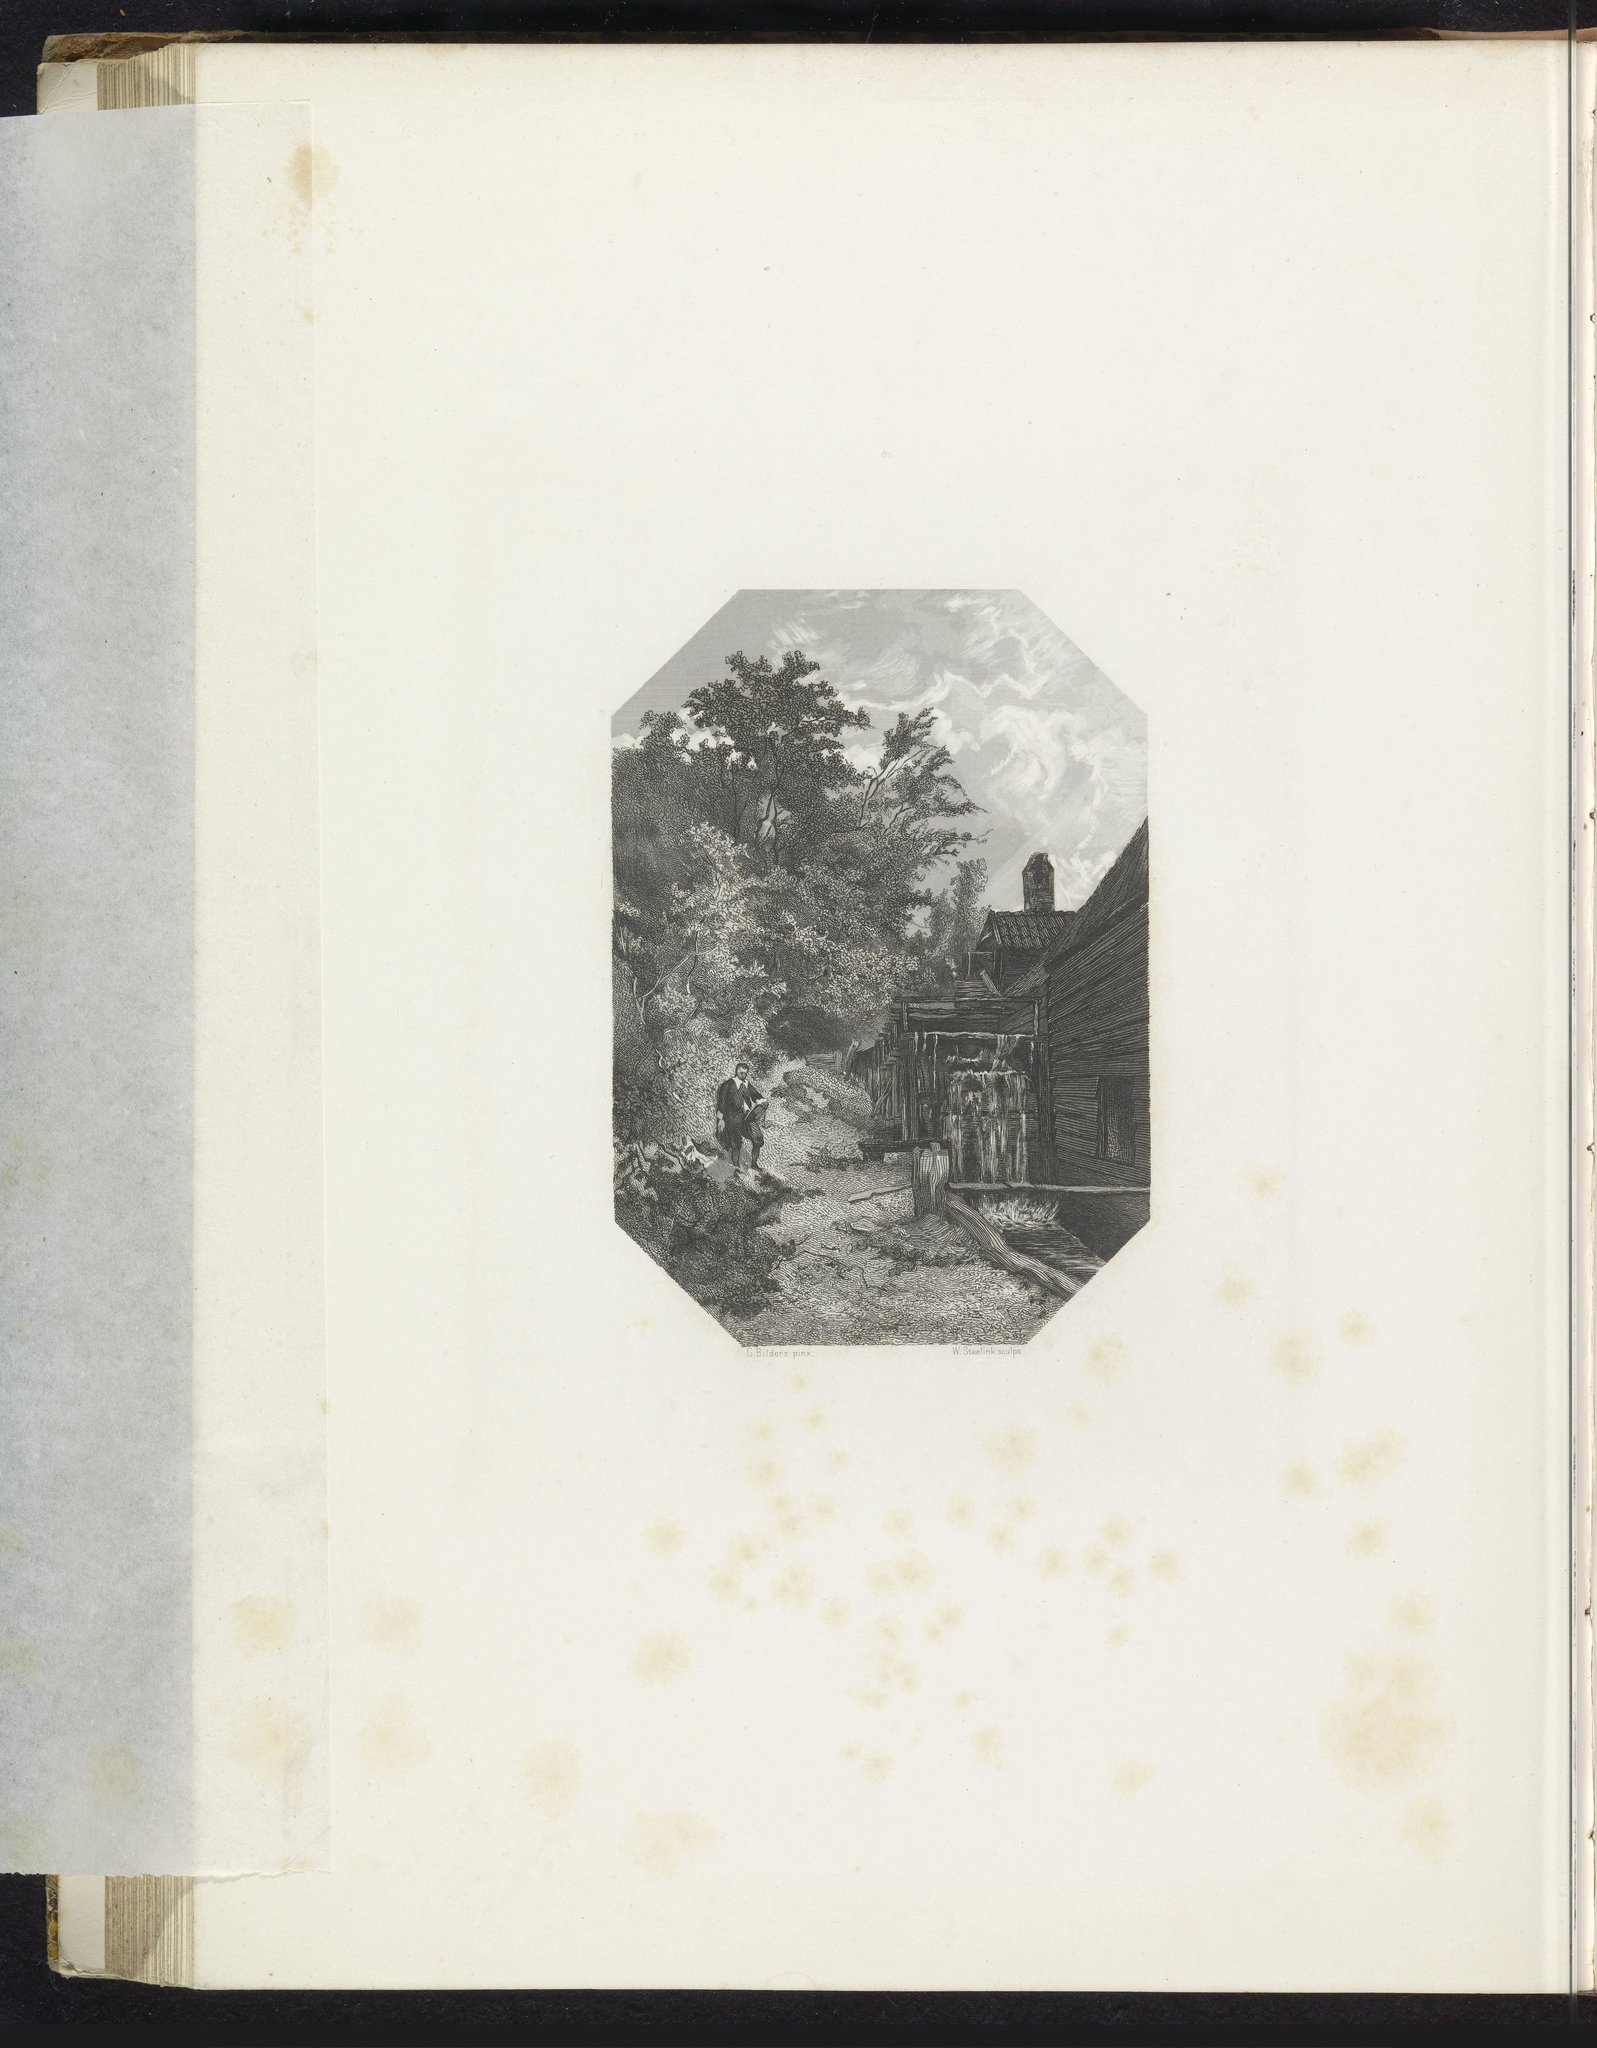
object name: history print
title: Jacob Ruysdaal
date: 1865-1870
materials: paper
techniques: engraving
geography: netherlands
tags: jacob van ruysdael, painter making preliminary designs, sketching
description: De schilder Jacob van Ruysdael schetsend bij een watermolen, ca. 1670. Onderdeel van de groep staalgravures naar de schilderijen van de Historische Galerij der Maatschappij Arti et Amicitiae.